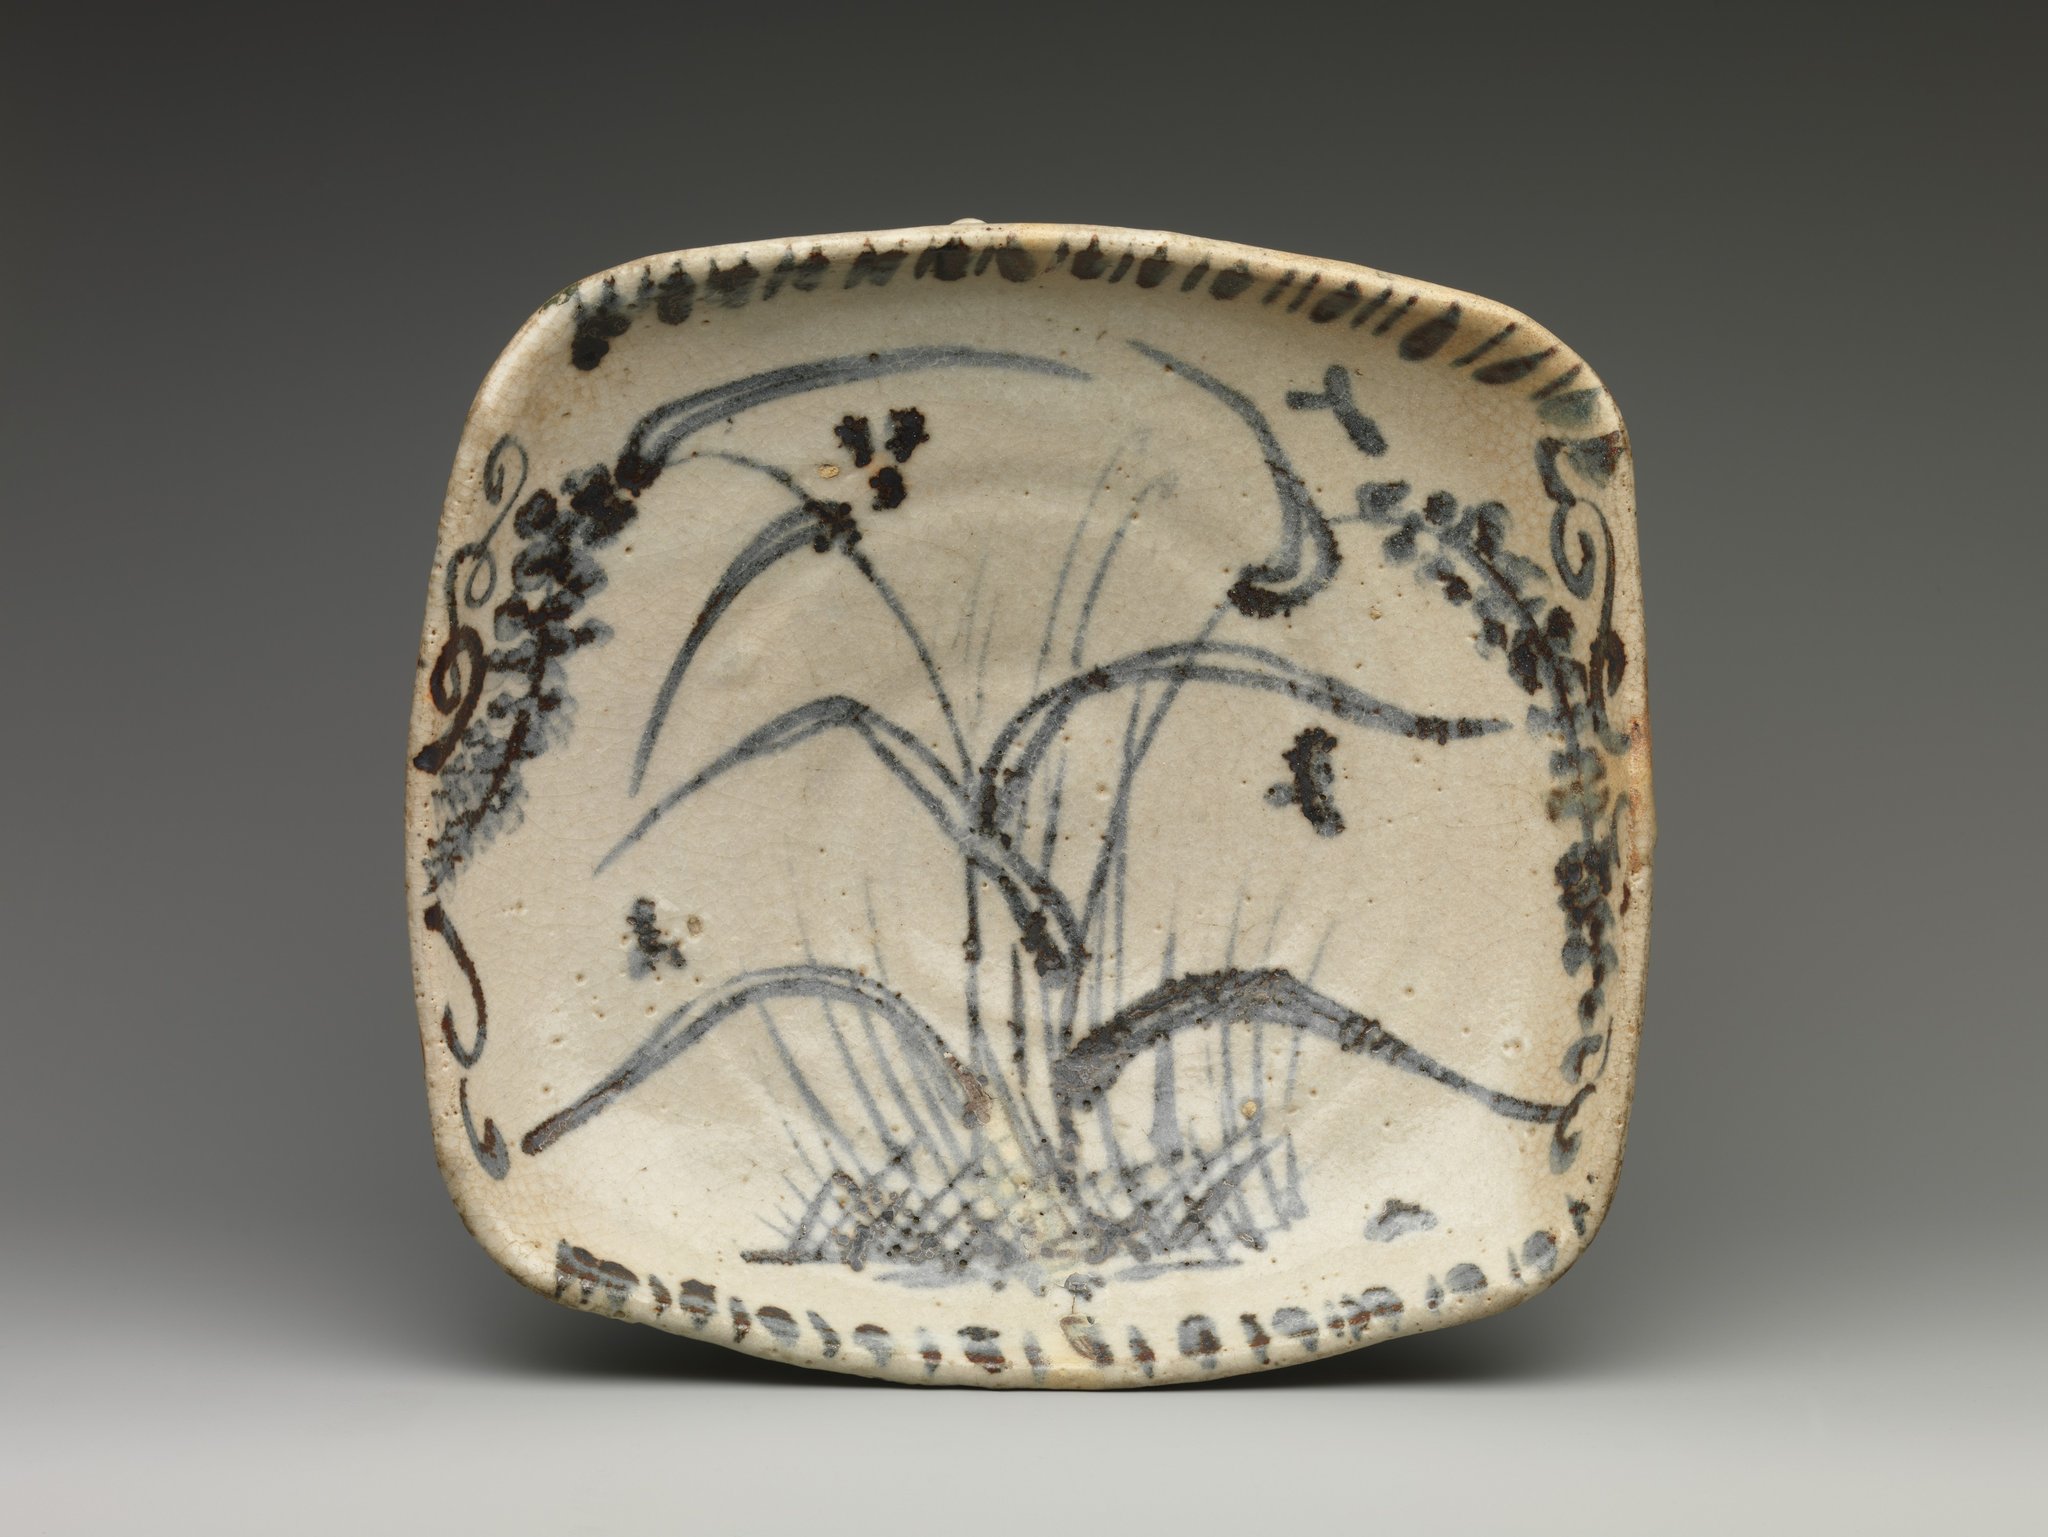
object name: dish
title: Dish with Reeds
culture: japanese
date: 1567-1633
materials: iron, stoneware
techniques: underglaze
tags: plants